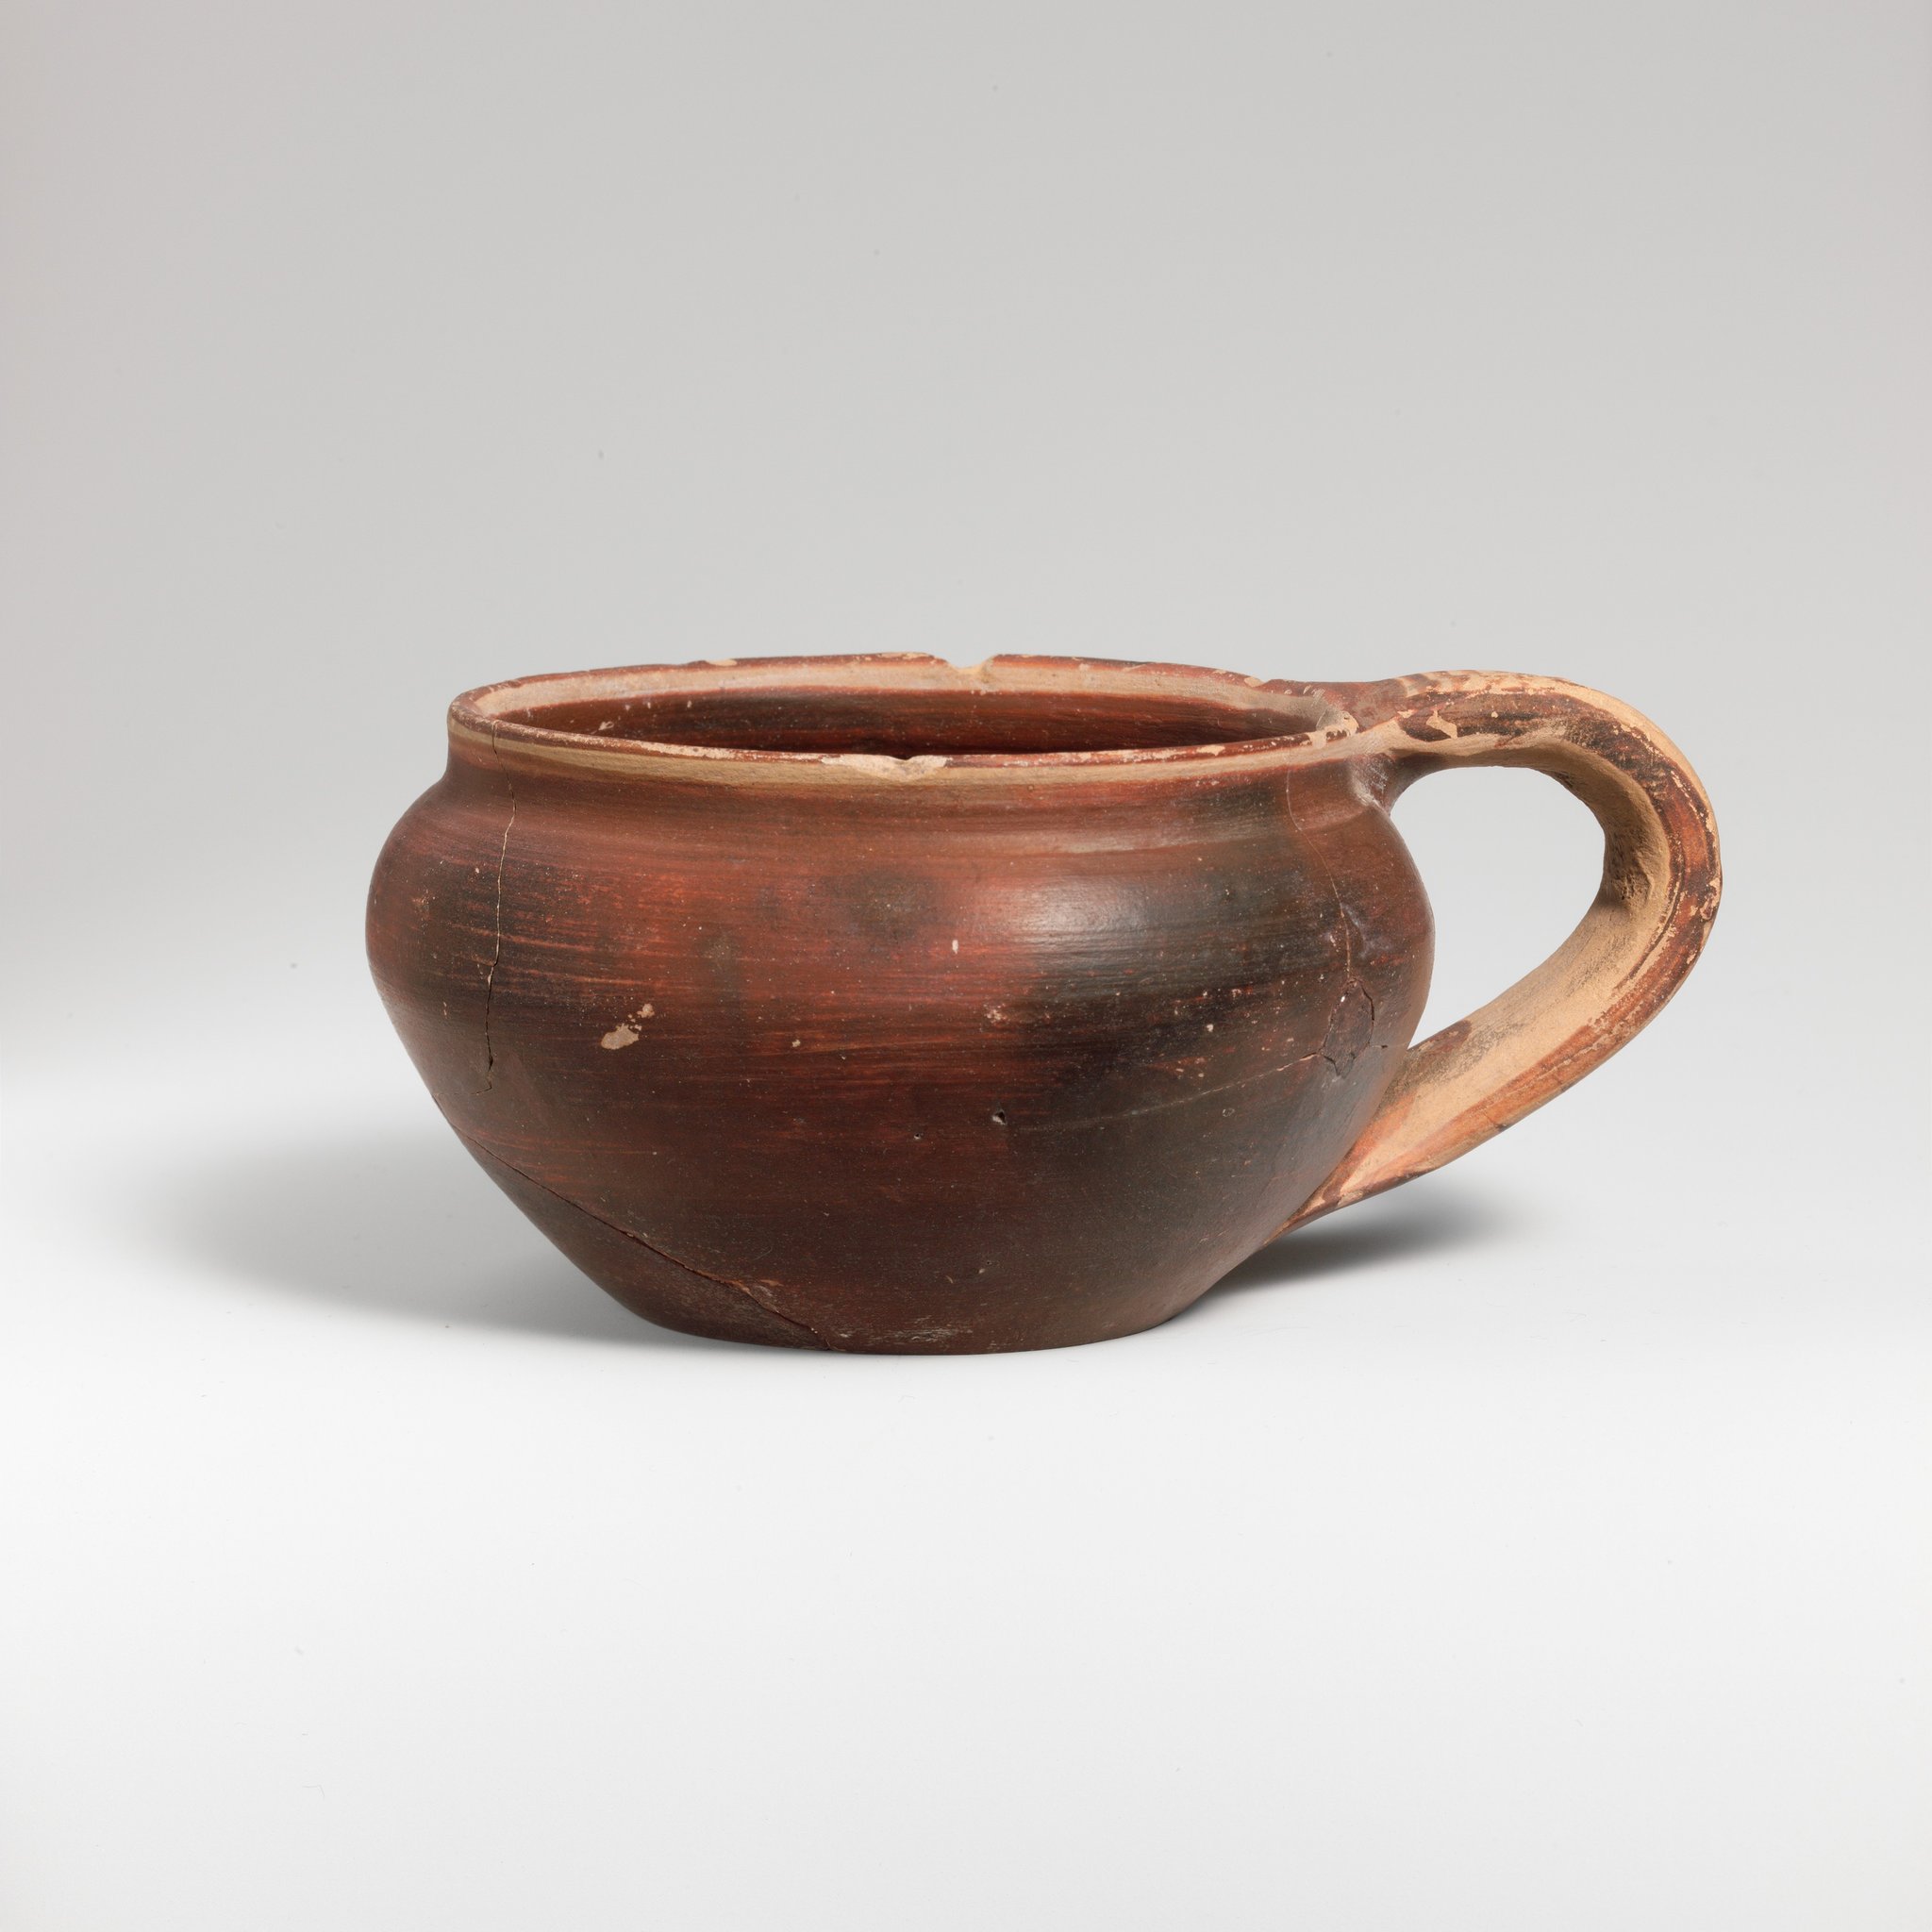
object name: cup, one handled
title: Terracotta one-handled cup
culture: greek, attic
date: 734-701 BCE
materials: terracotta